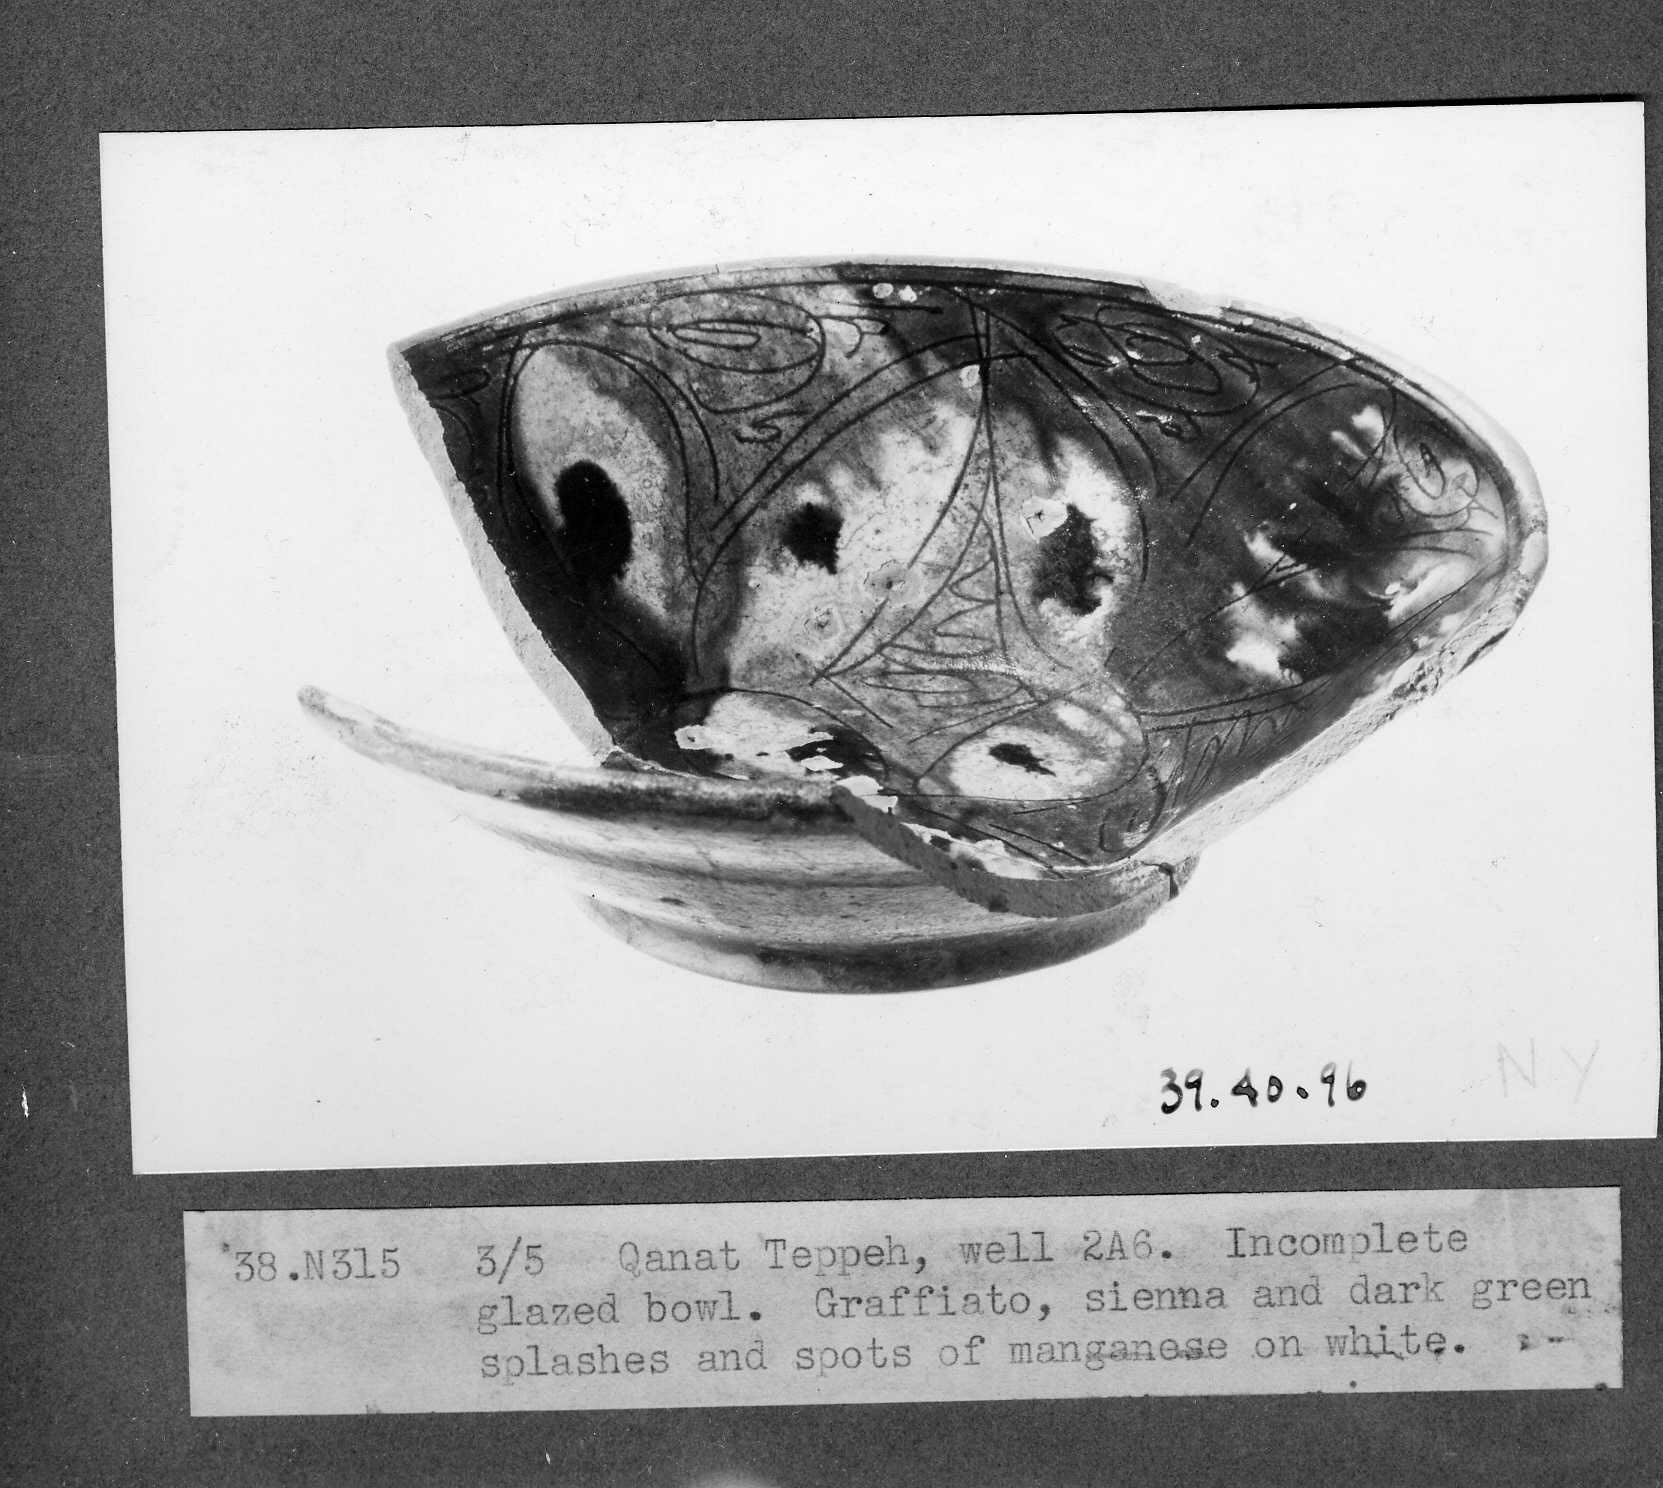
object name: fragment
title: Fragments of a Plate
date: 801-1000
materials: earthenware, glaze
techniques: painting, polychrome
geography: iran